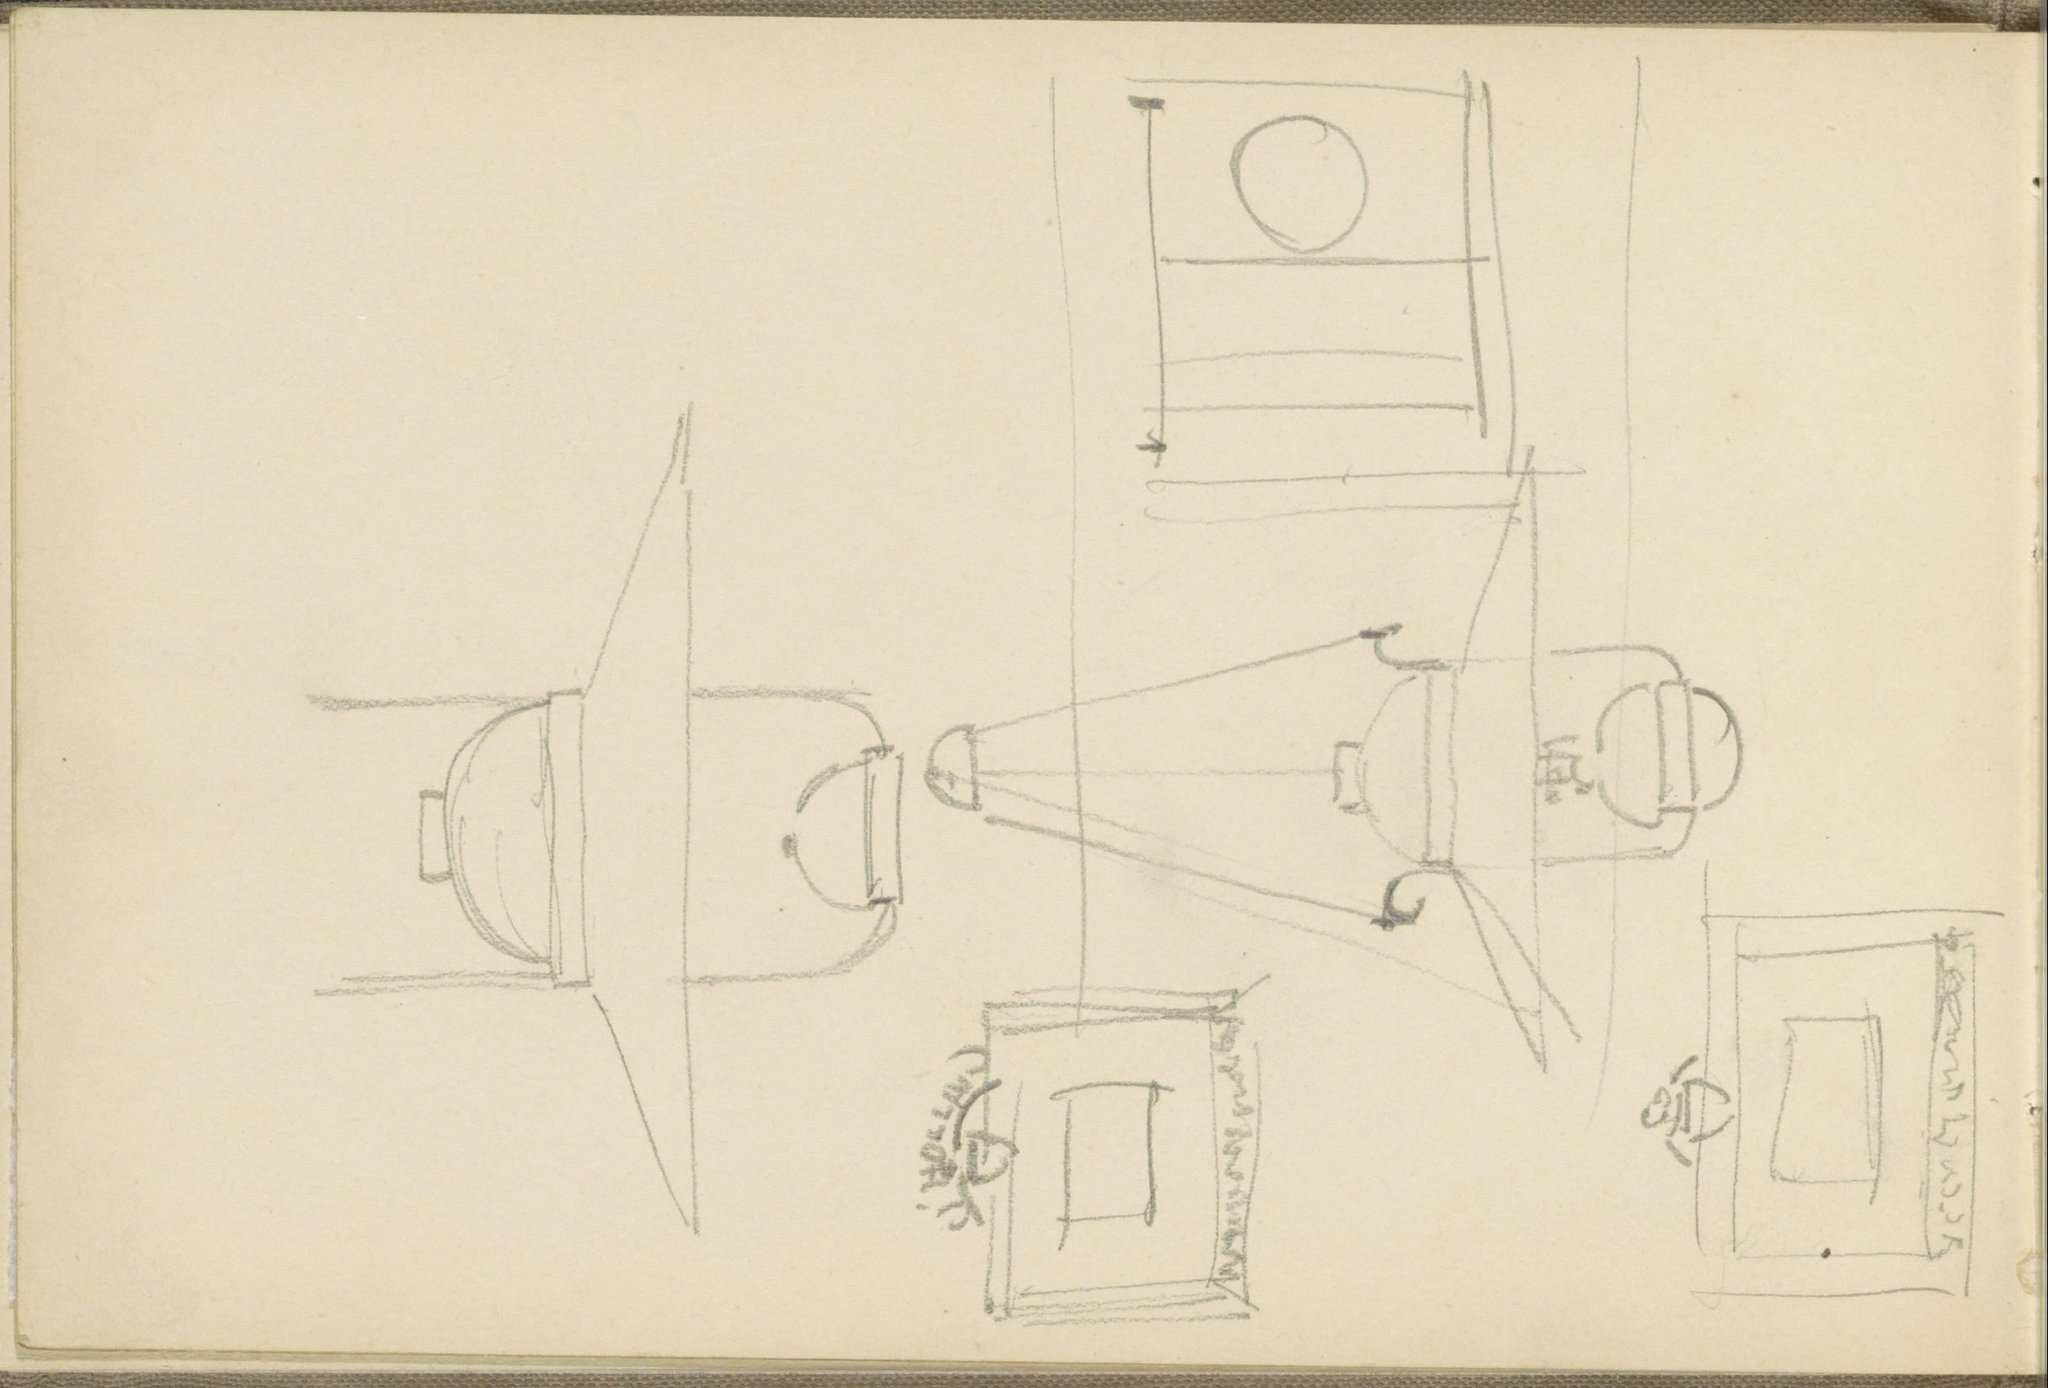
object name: sketchbook leaf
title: Ontwerpen voor elektrische hanglampen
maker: carel adolph lion cachet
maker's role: draughtsman, print maker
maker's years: 1864-1945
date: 1905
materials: paper, pencil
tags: frame of painting, etc., electric lamp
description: Tevens studies van lijsten. Blad 17 verso uit een schetsboek met 27 bladen.